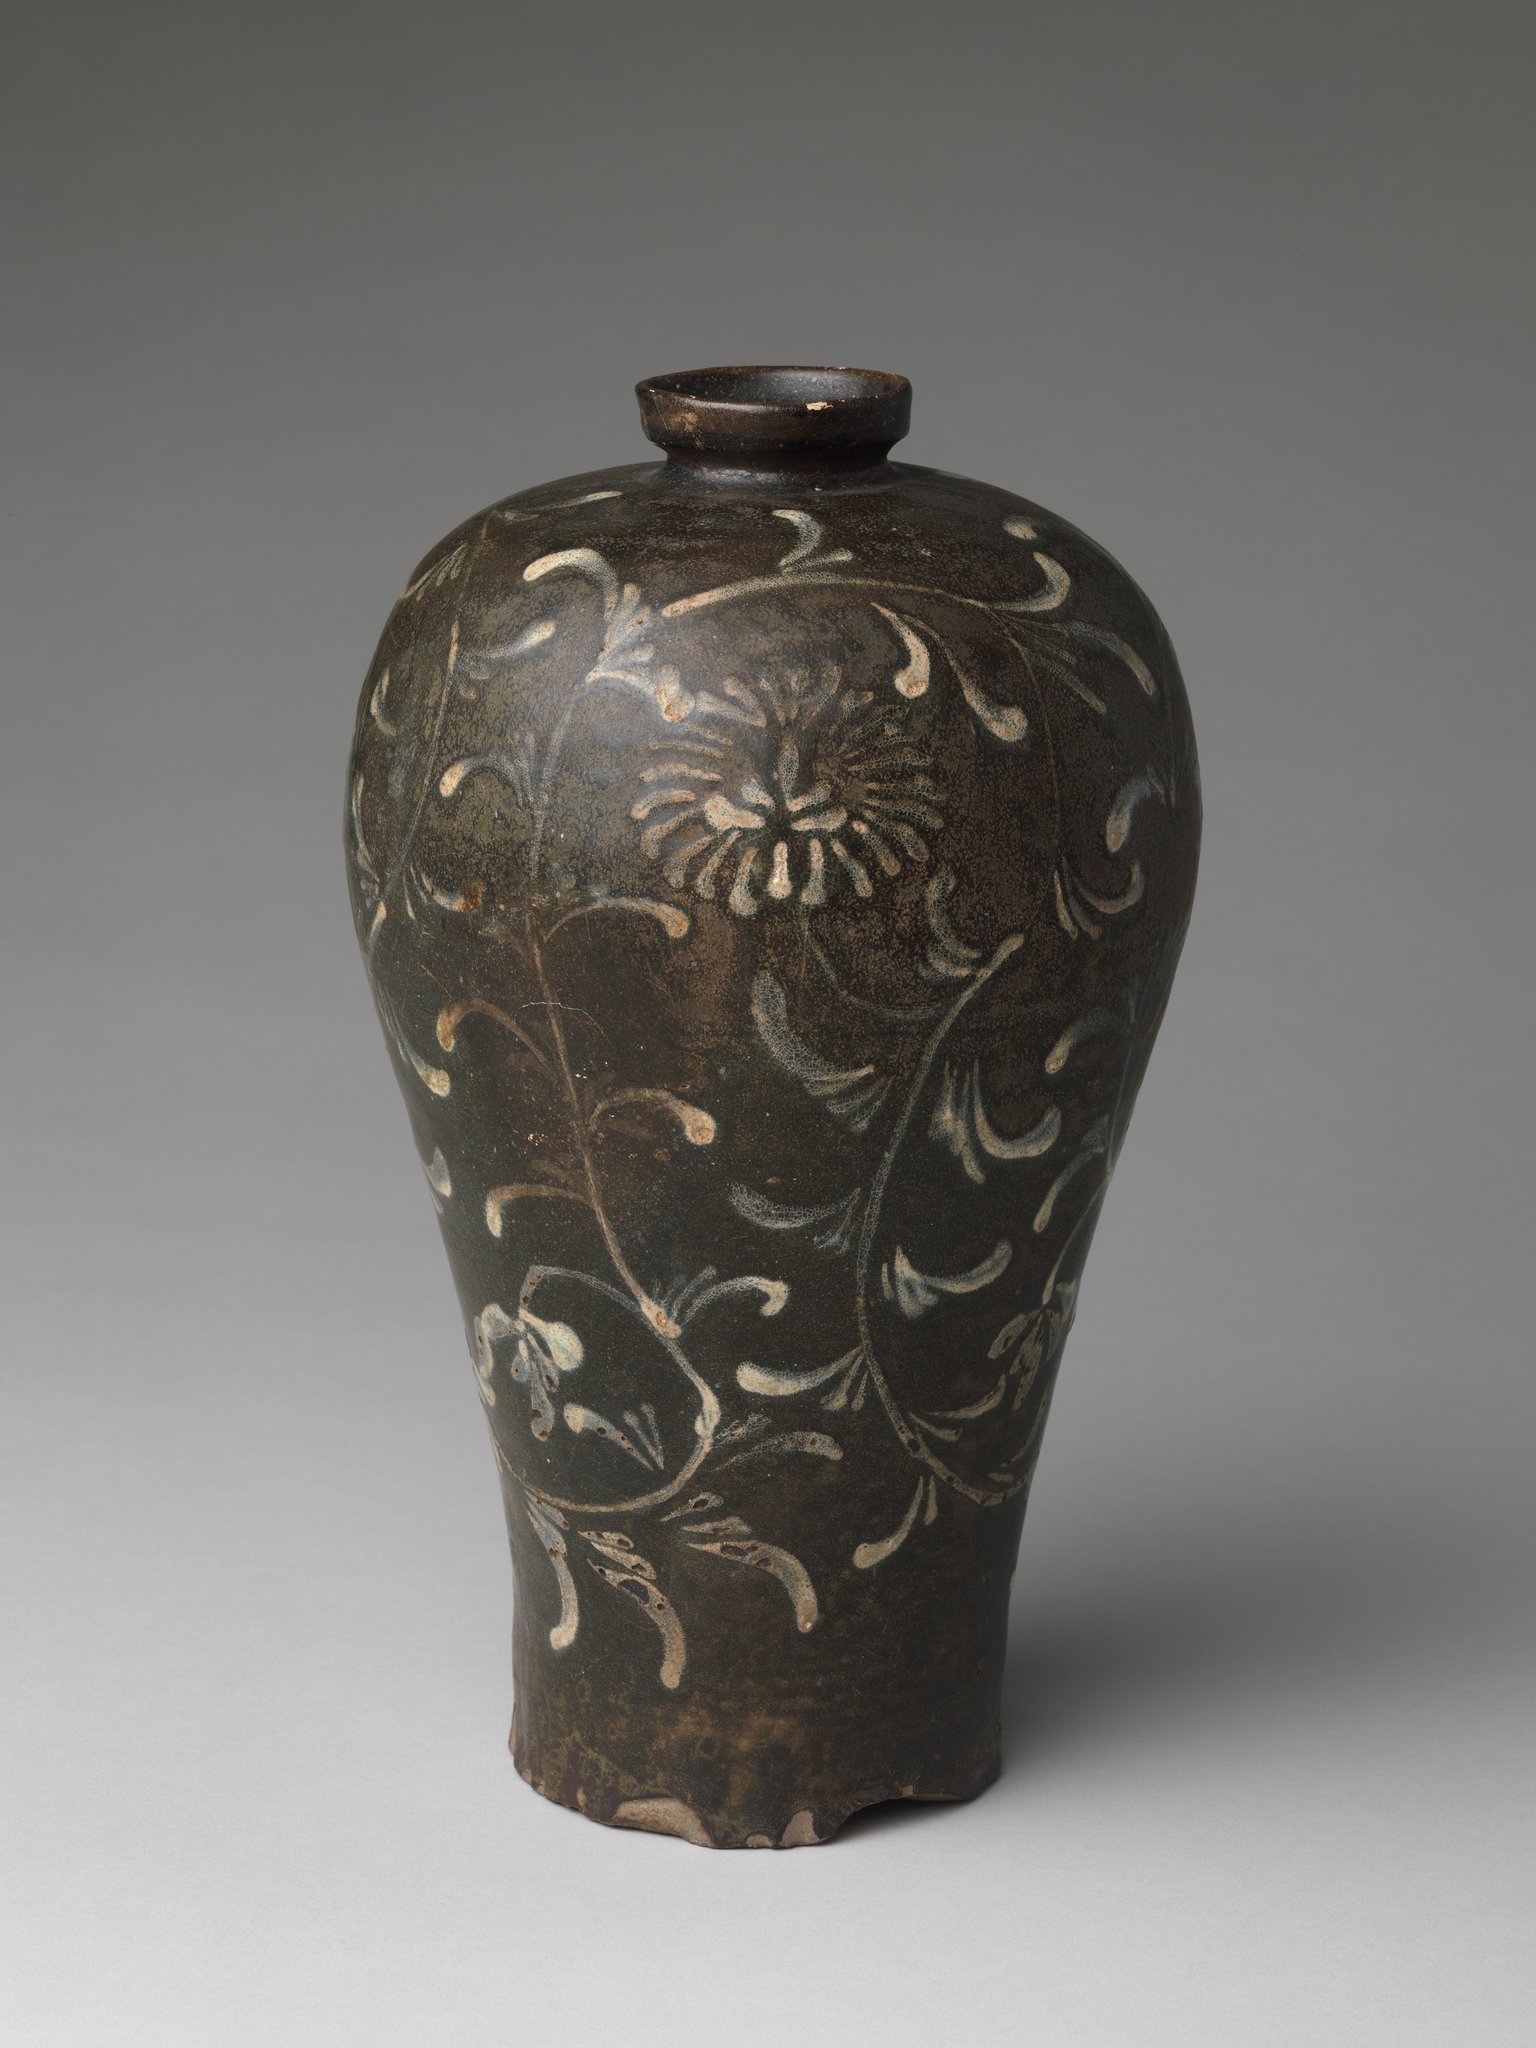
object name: vase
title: Maebyeong with chrysanthemum decoration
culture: korean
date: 1201-1300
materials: ceramic glaze, glaze, iron, stoneware